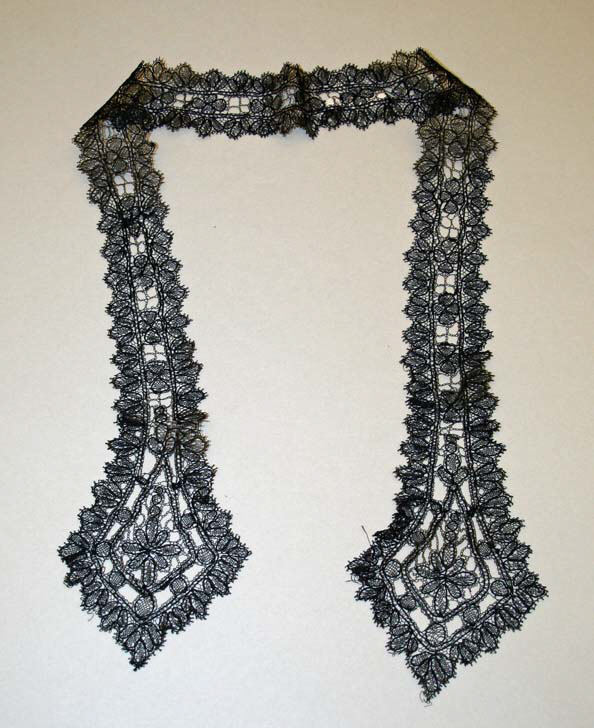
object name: barbe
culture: american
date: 1870-1892